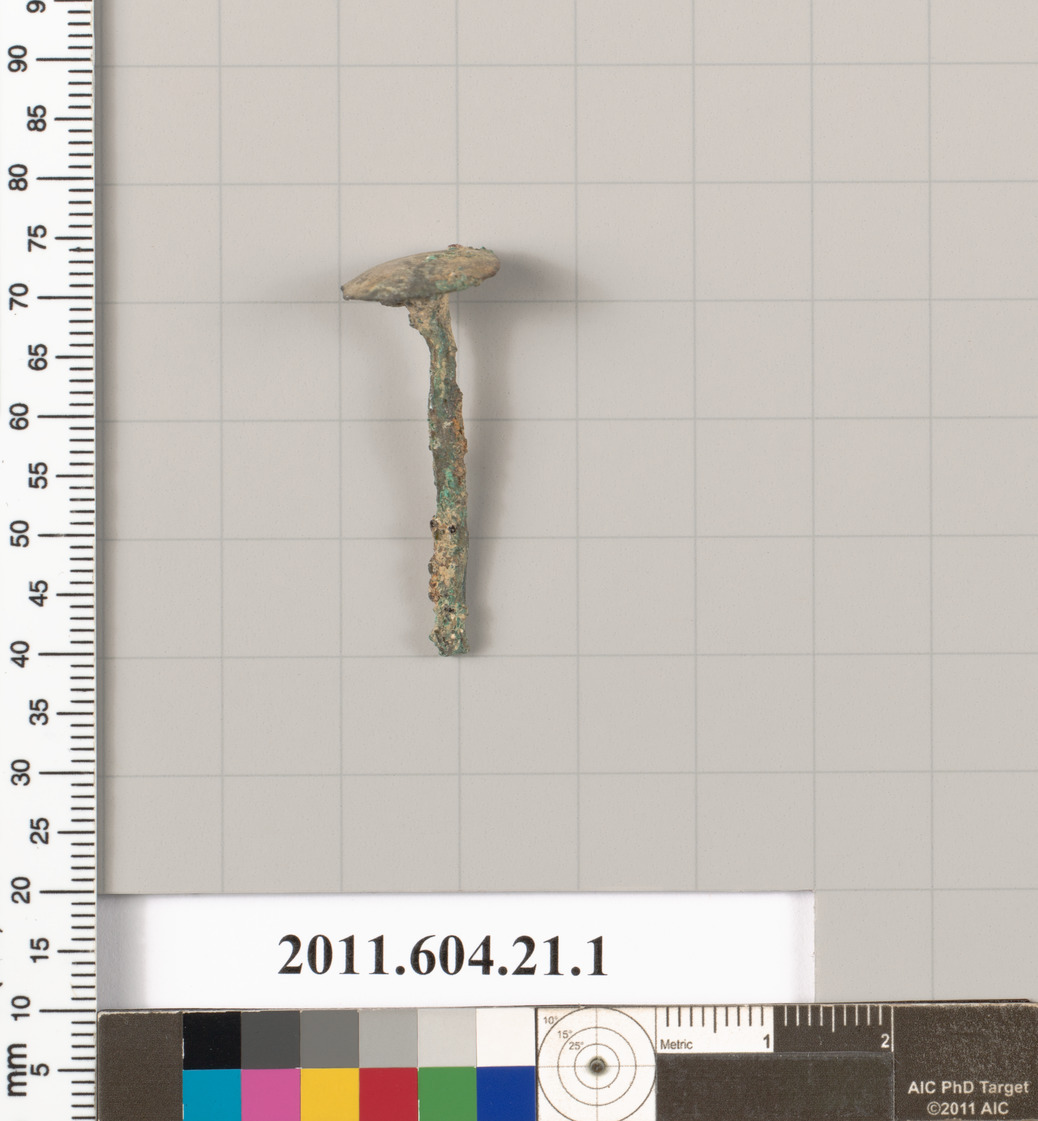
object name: bronze nail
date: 700-501 BCE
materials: bronze